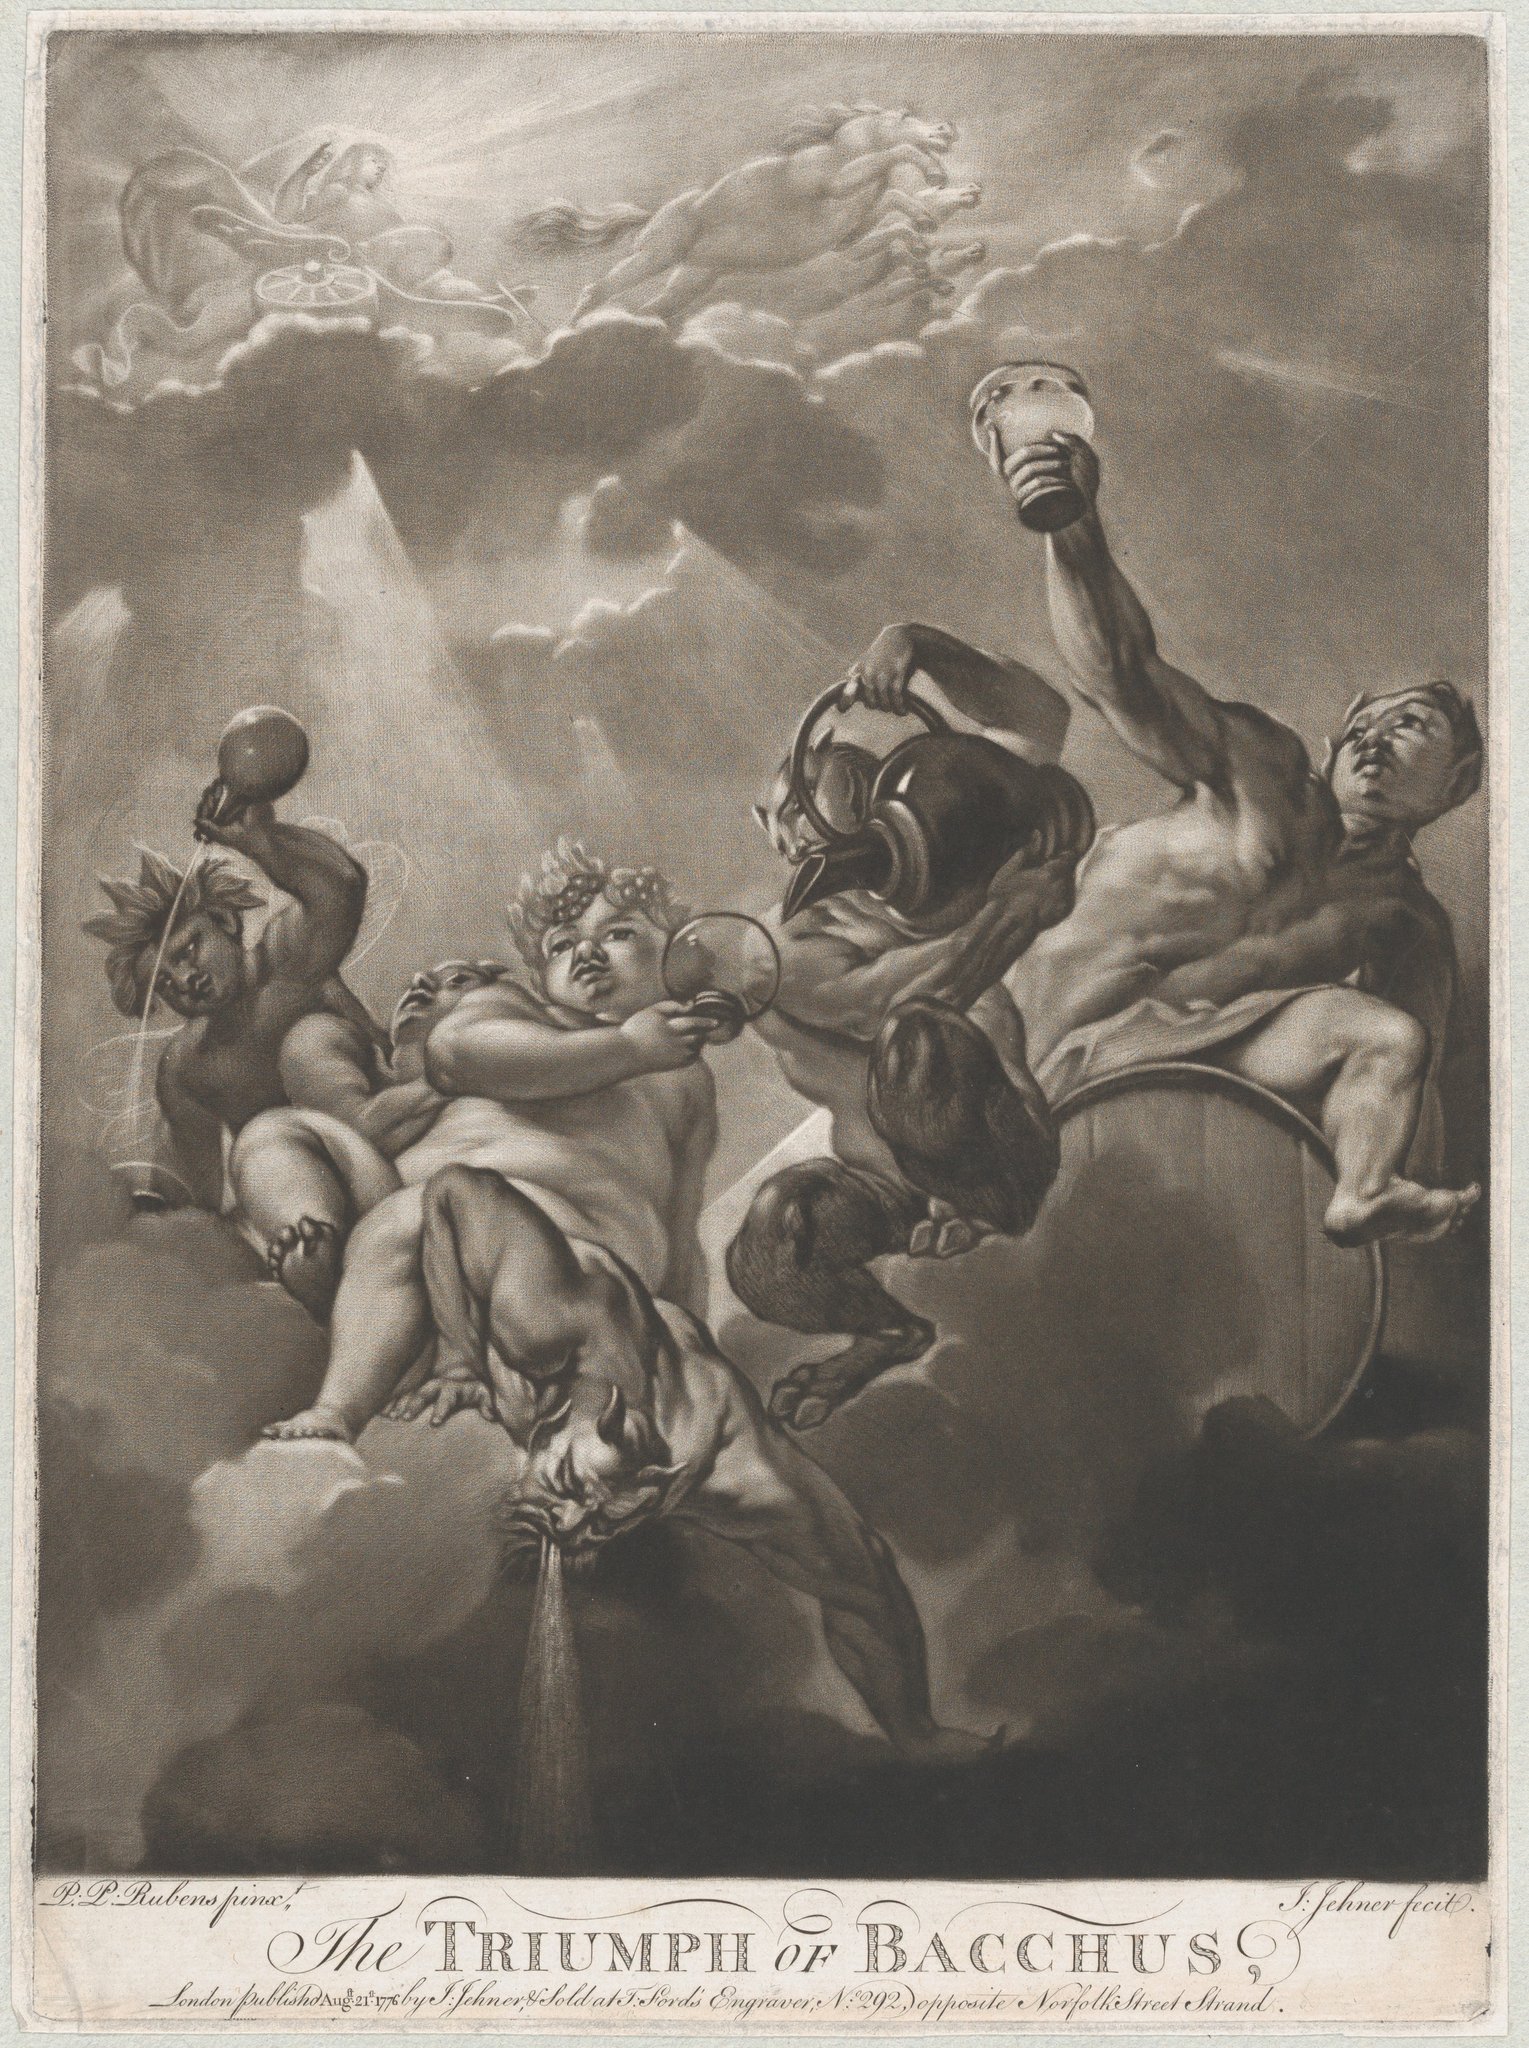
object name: print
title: The Triumph of Bacchus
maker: isaac jehner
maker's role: artist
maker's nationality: british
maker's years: 1750-1818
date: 1776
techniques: mezzotint